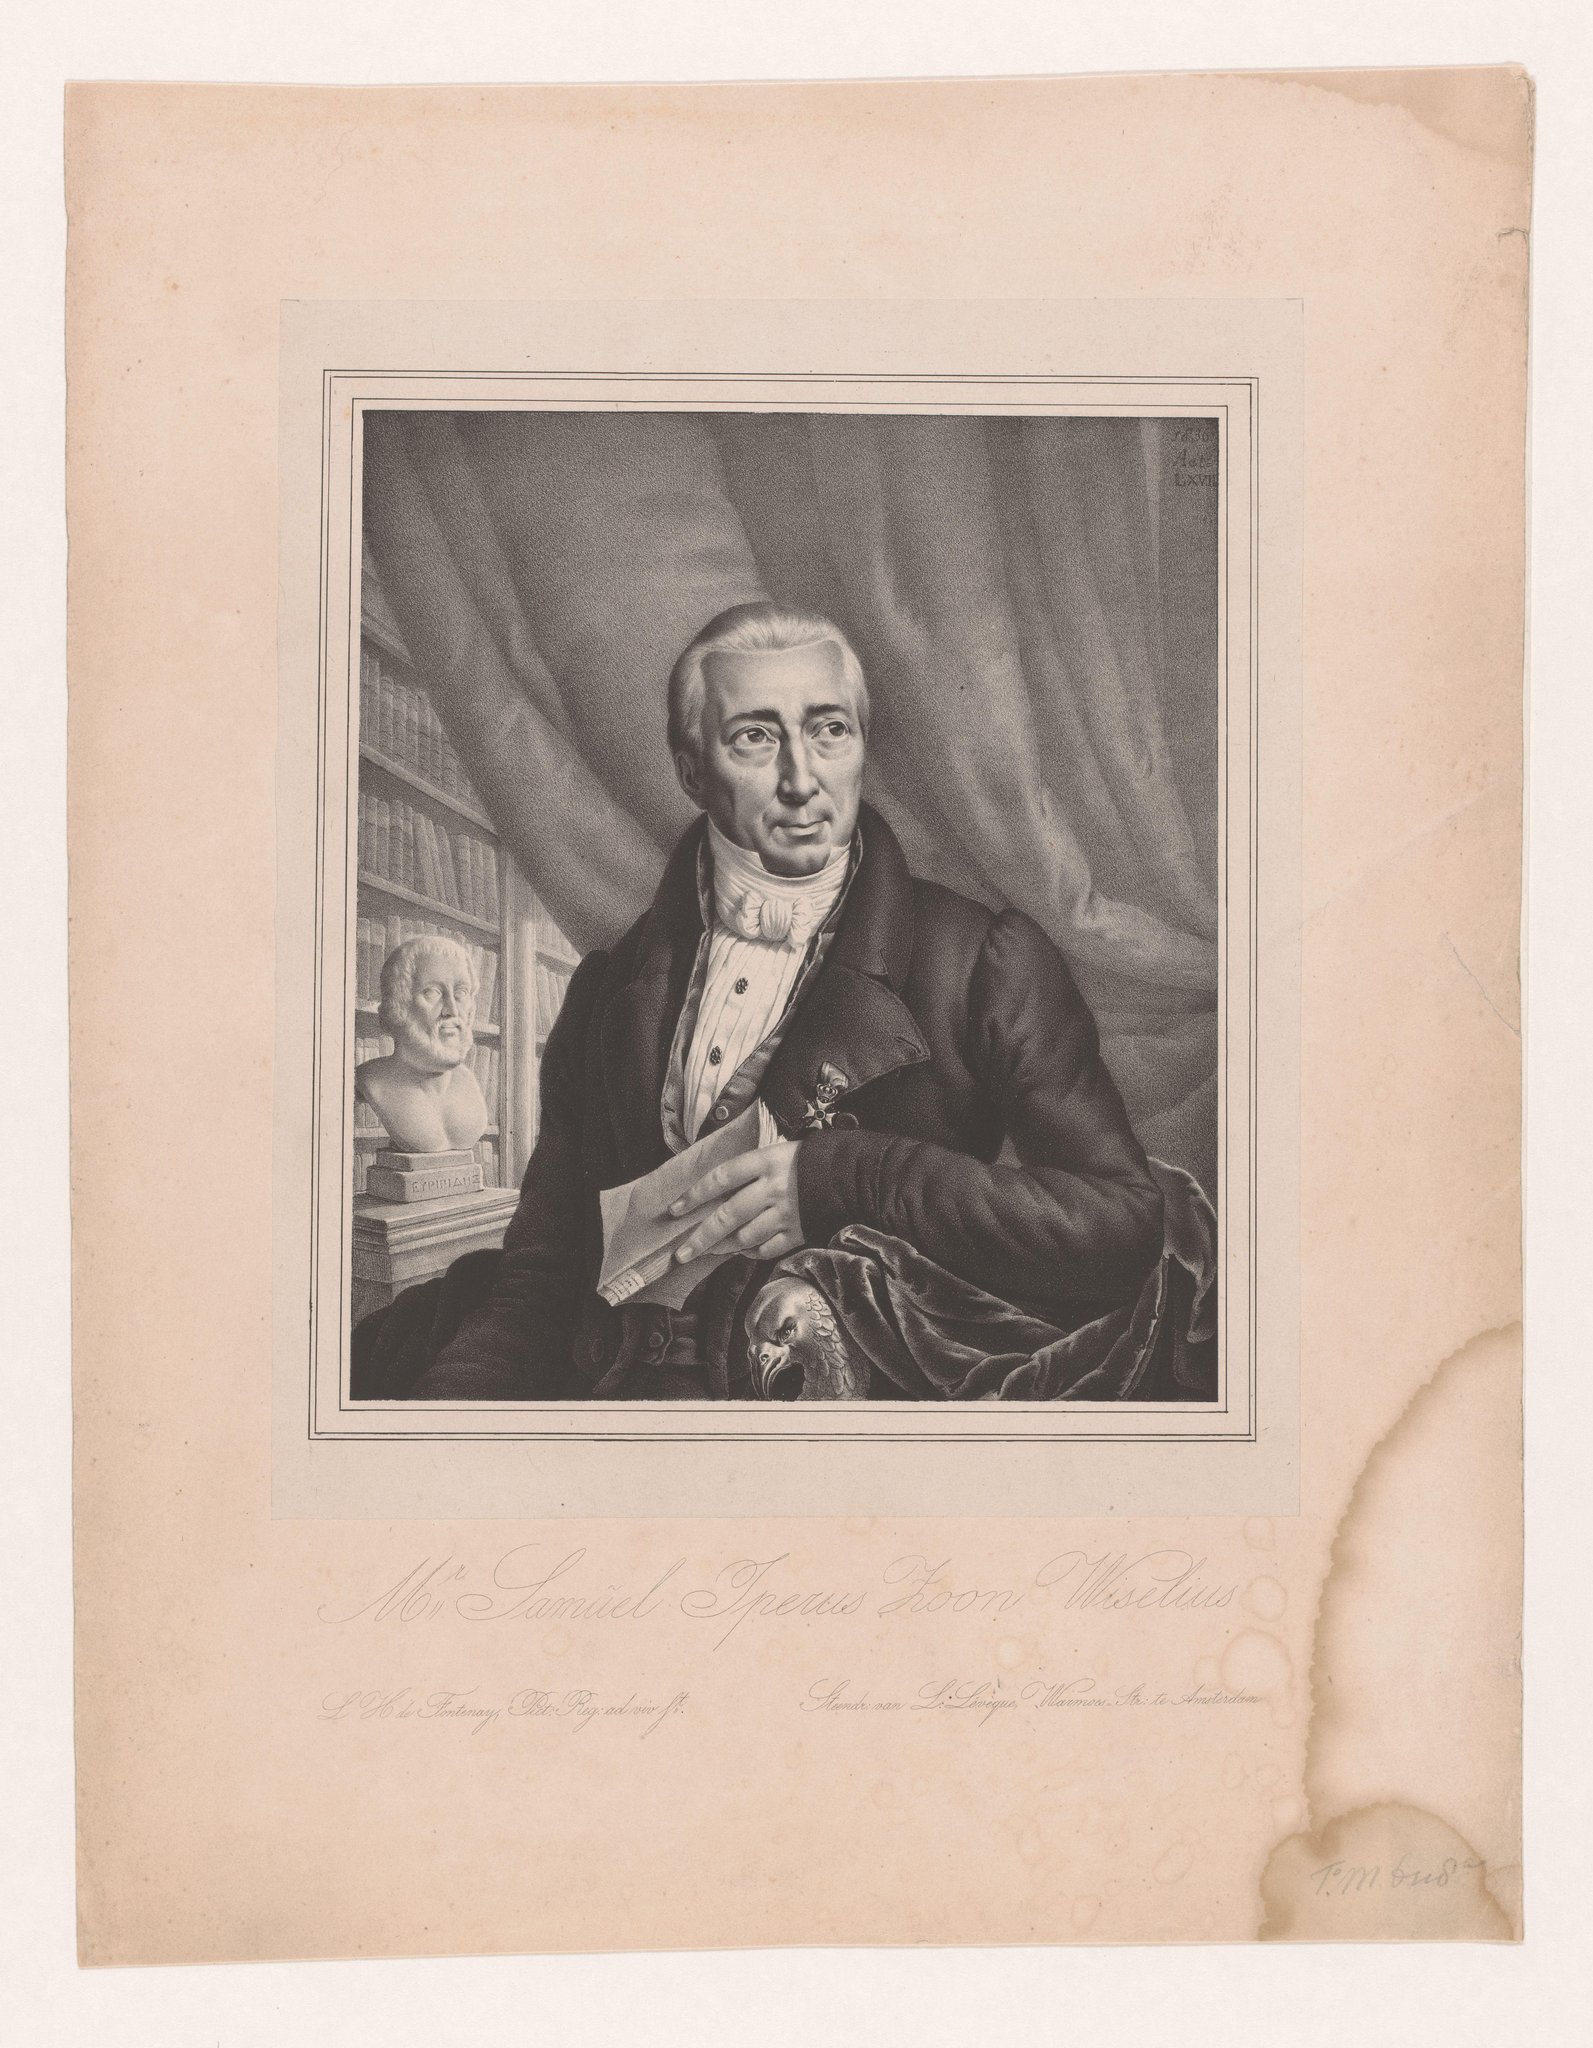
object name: print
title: Portret van Samurel Iperusz. Wiselius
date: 1810-1853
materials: paper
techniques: lithograph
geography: amsterdam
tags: amsterdam, curtains, historical persons (+ half-length portrait), sculpture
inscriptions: collector's mark: Lugt 2228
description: De geportretteerde zit in een stoel met een boek in zijn linkerhand. De armleuning van de stoel is gedecoreerd met de kop van een roofvogel. Achter hem hangt een opgetrokken gordijn. Daarachter is een studeervertrek of bibliotheek zichtbaar met een boekenkast en een portretbuste van Euripides.